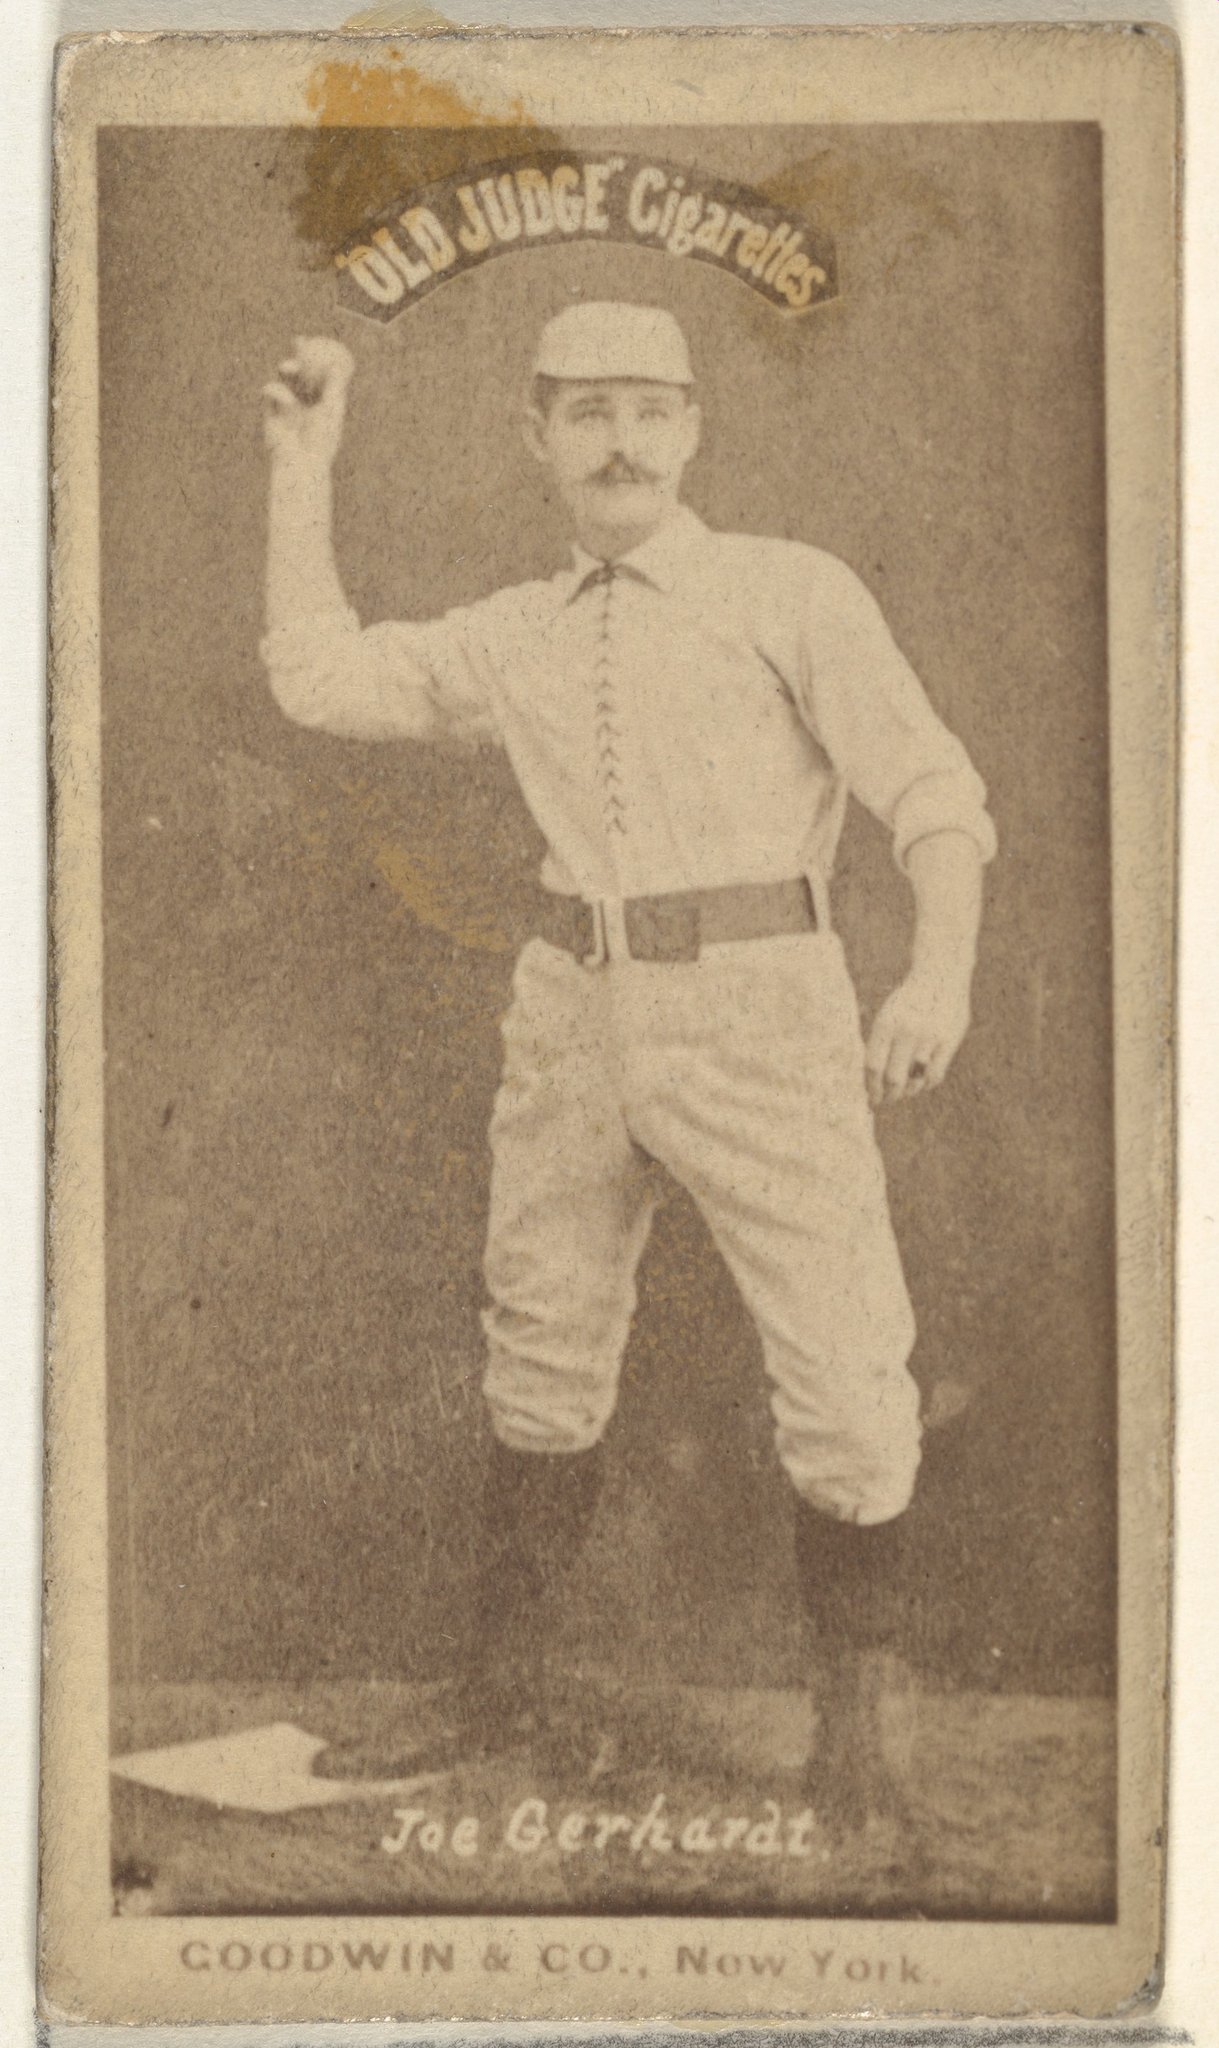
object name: baseball card, photograph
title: John Joseph "Joe" Gerhardt, from the Old Judge series (N172) for Old Judge Cigarettes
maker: goodwin & company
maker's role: publisher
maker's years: 1850-1950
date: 1887-1890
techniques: albumen silver print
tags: men,portraits,baseball,athletes